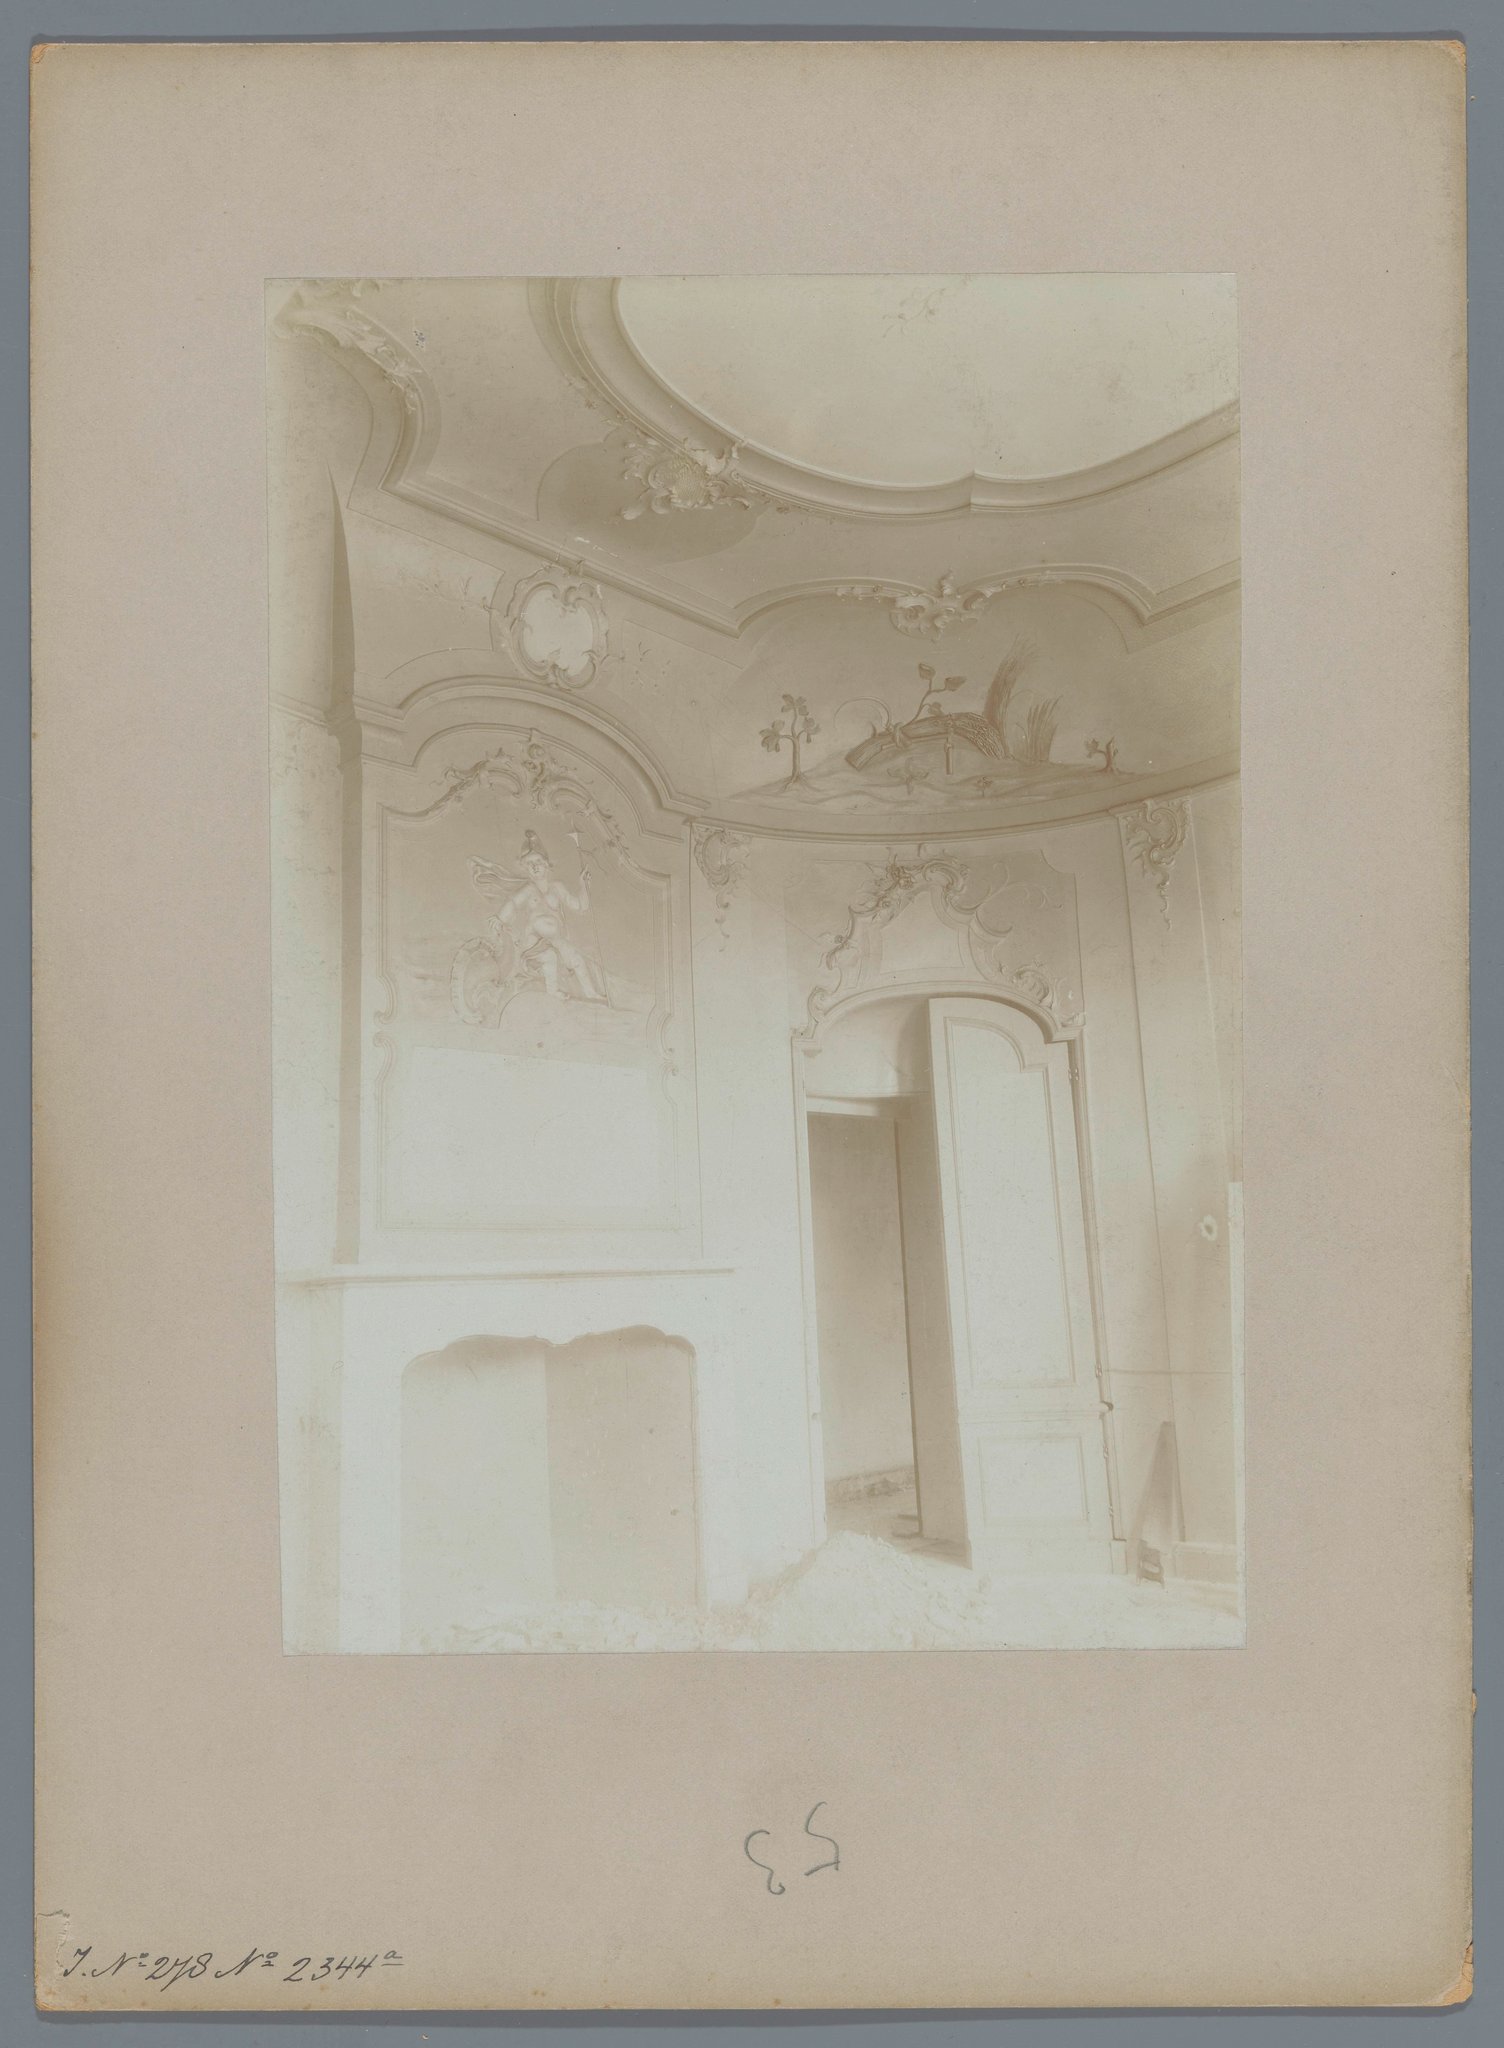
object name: photograph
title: Interieur van jachtslot De Wildbaan te Wolvega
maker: Anonymous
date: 1910-1913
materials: cardboard, photographic support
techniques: collodion silver print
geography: wolvega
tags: picture, painting, interior ~ representation of a building, hunting-seat, hunting lodge, 'rendez-vous de chasse', 'jagdschloss'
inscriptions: inscription: ‘neg. no 17188 foto no 24423’, annotation, inscription: ‘Koepel in het jachtslot ,,de Wildbaan'' te Wolvega gem. West-Stellingwerf Fr. Oct. 1913’